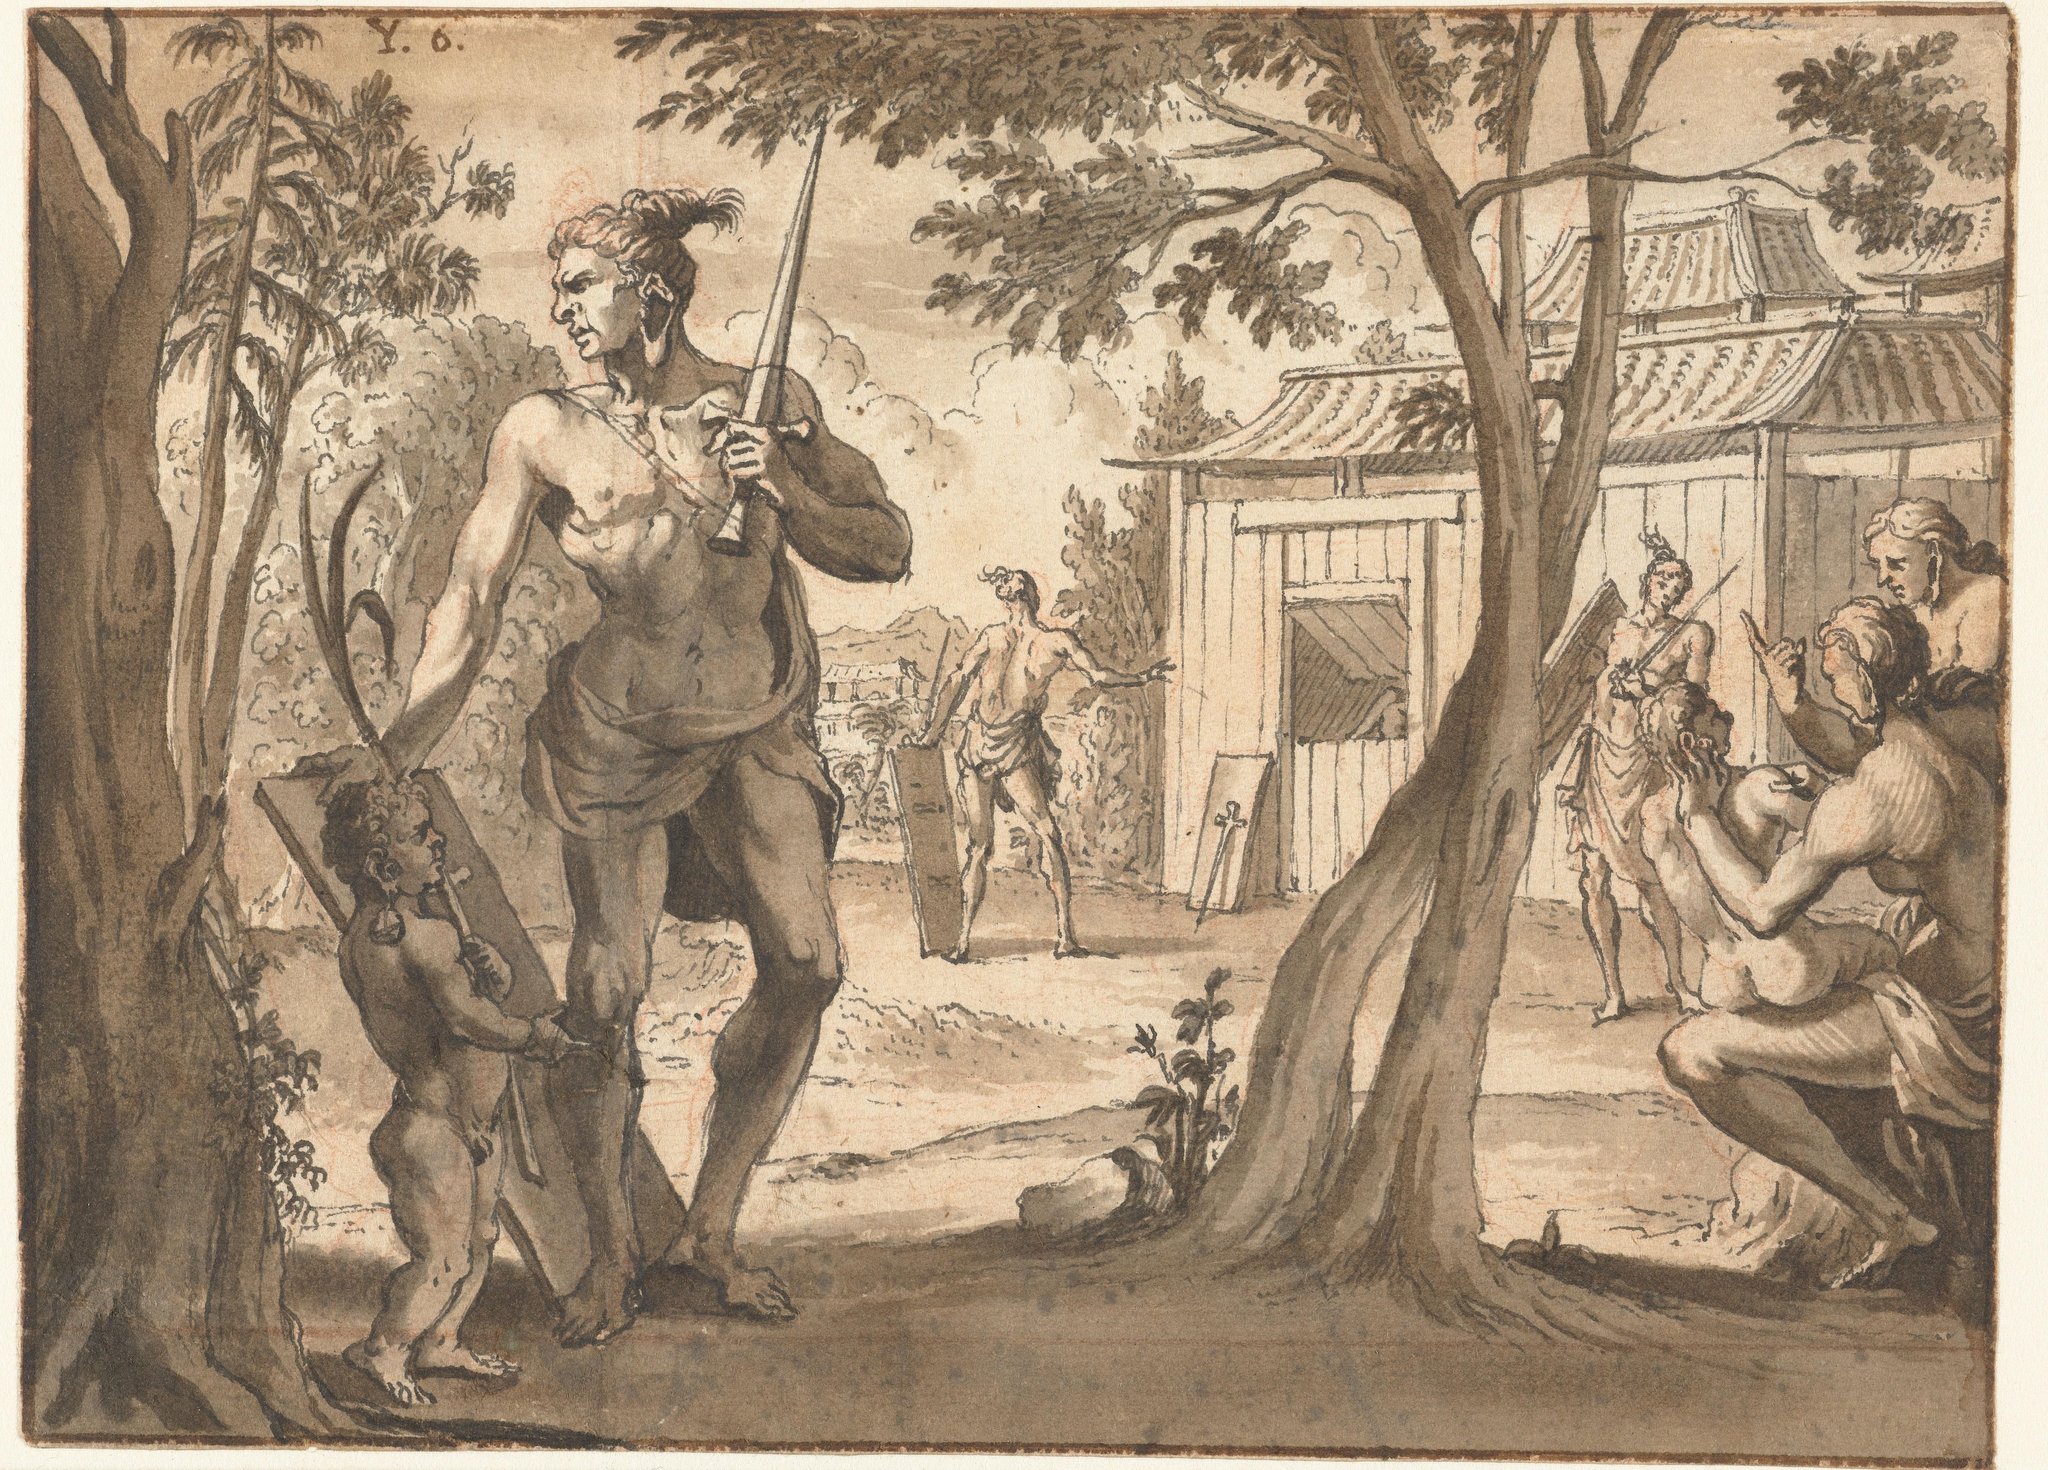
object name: design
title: Mensen bij een houten gebouw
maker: jan goeree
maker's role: draughtsman, print maker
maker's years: 1670-1731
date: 1704-1727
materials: chalk, ink, paper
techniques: brush, pen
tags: exploration, expedition, voyage of discovery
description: Links op de voorgrond staat een man met lendendoek, zwaard en schild. Rechts op de voorgrond twee vrouwen met een kind. Naast de man staat een kind. De figuren hebben opvallende uitgerekte oorlellen. Het staande kind lijkt een gewichtje aan het rechteroor te hebben hangen. Op de achtergrond een houten gebouw en nog enkele andere figuren. Ontwerp voor een boekillustratie.